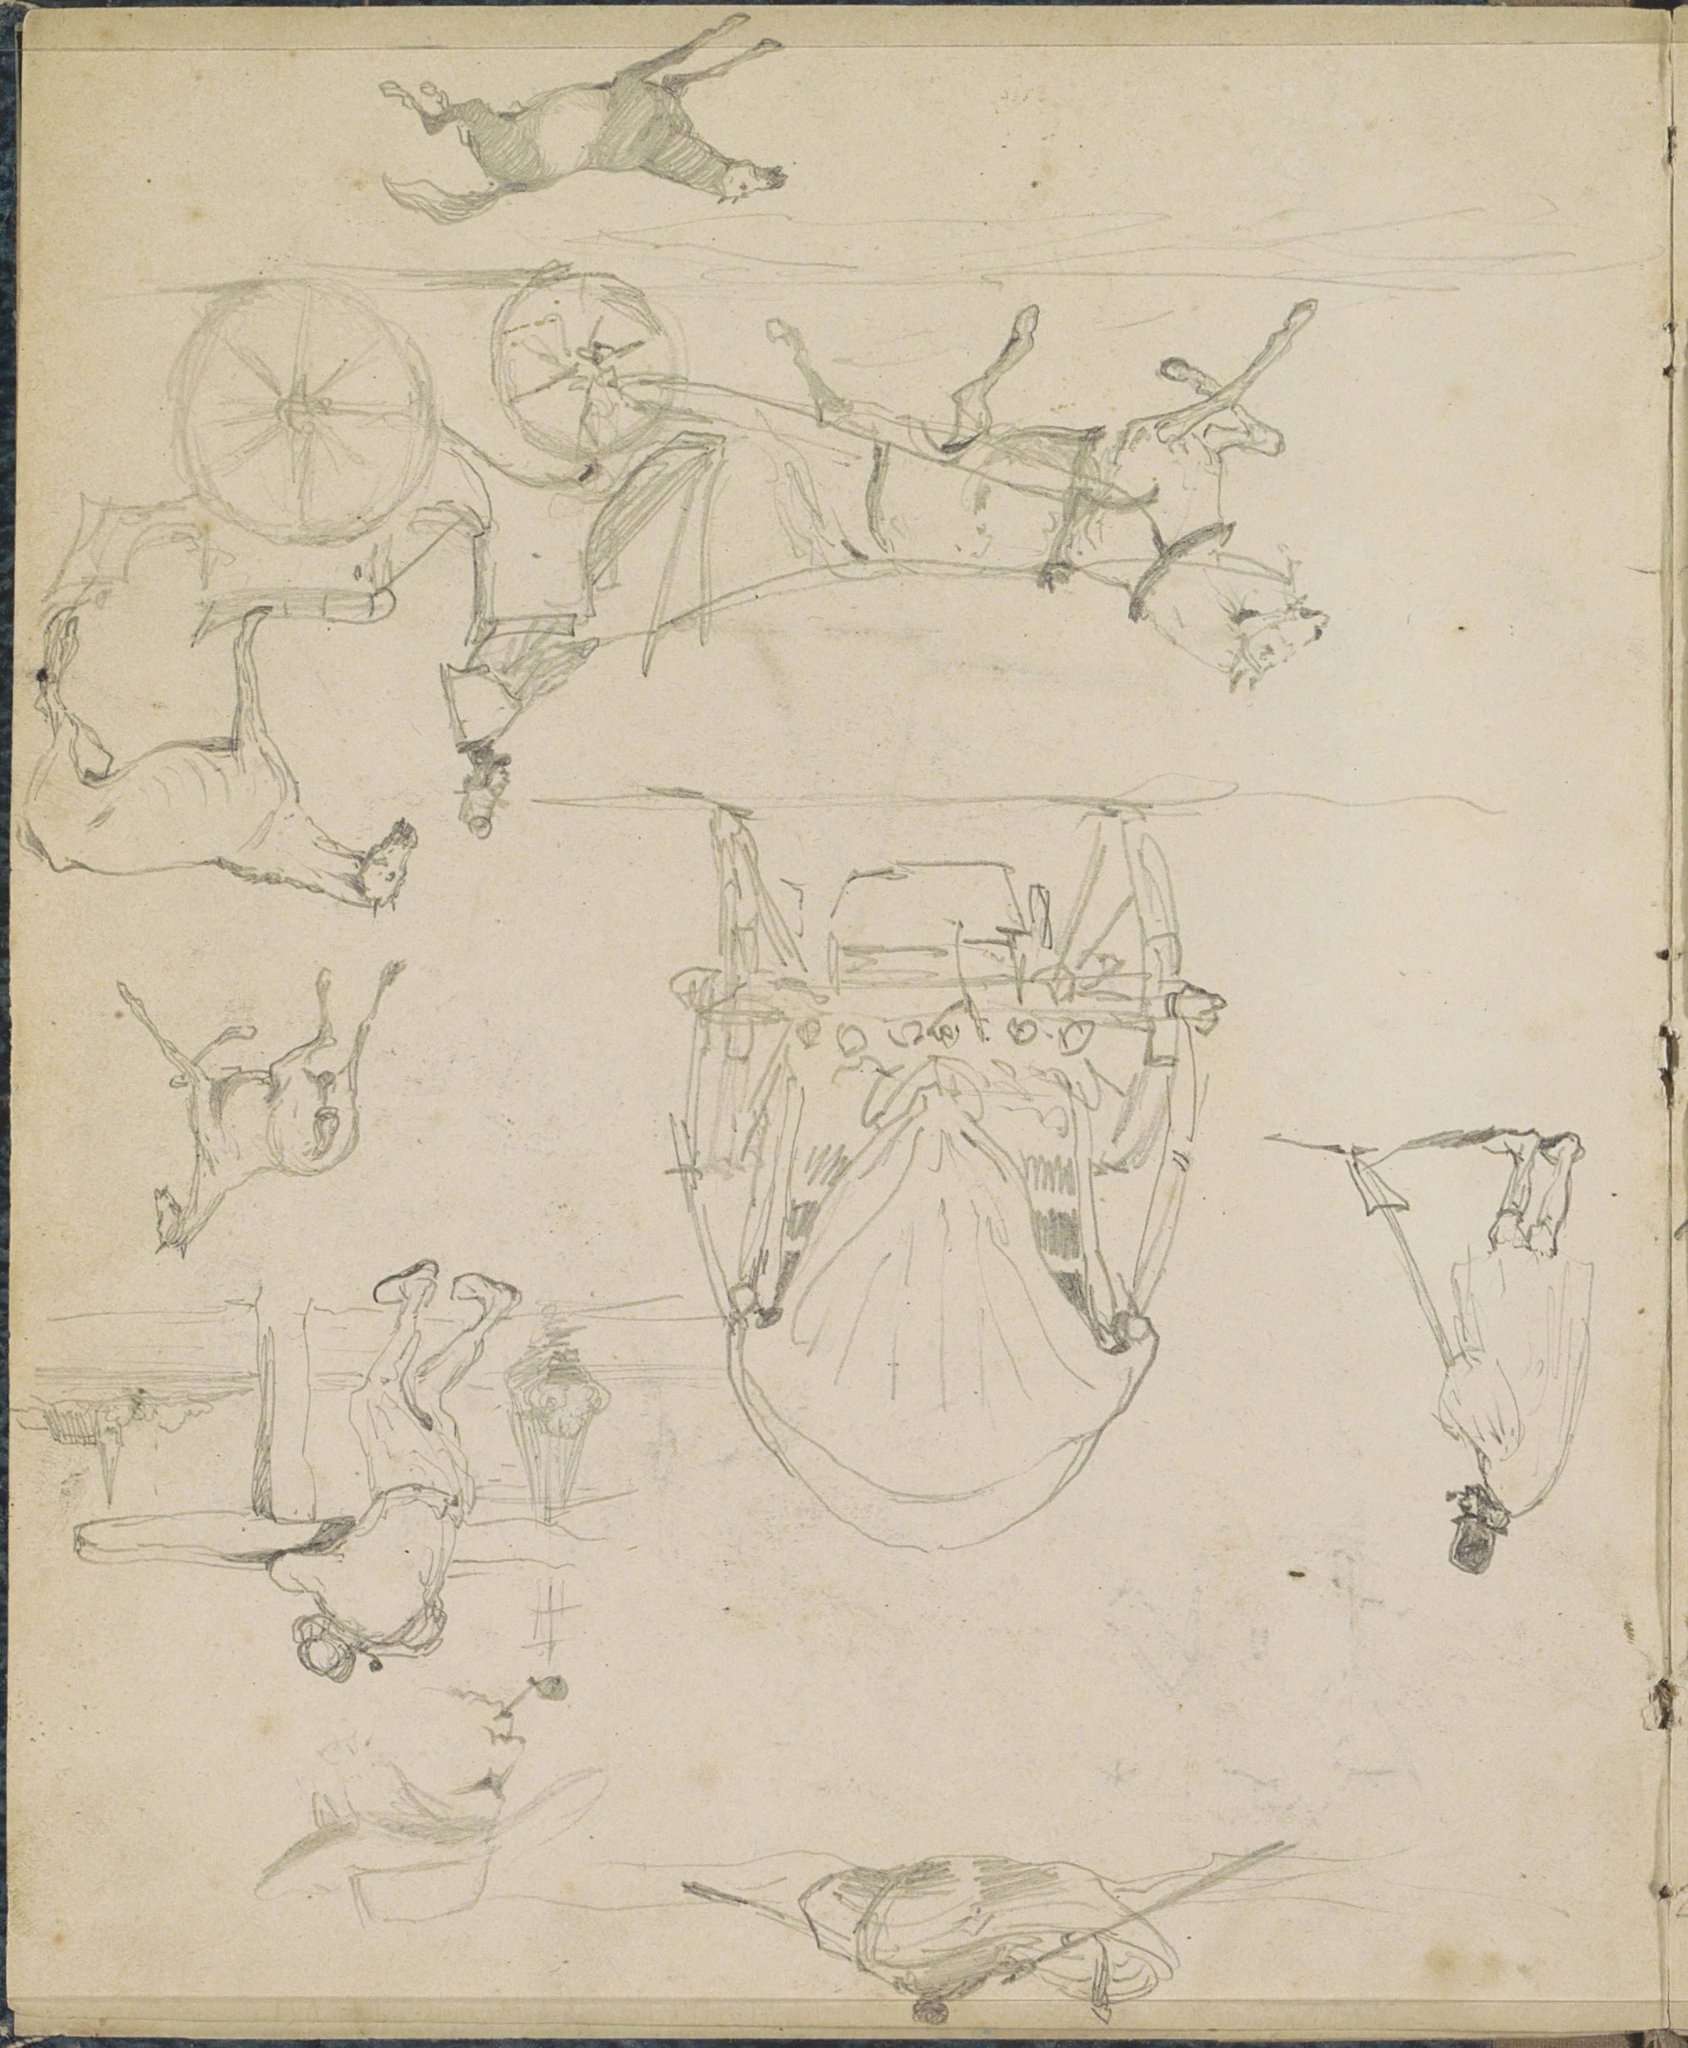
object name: sketchbook leaf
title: Roeiboot, paardenkoets en een huifkar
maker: johannes tavenraat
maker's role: draughtsman, painter, print maker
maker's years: 1809-1881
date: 1841-1853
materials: paper, pencil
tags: animal traction, animal-drawn vehicle (carriage etc.), rowing-boat, canoe, etc., covered wagon, hooded wagon, horse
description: Tevens studies van een mannenkop, man met schoffel en paarden. Blad 1 verso uit een schetsboek met 87 bladen.